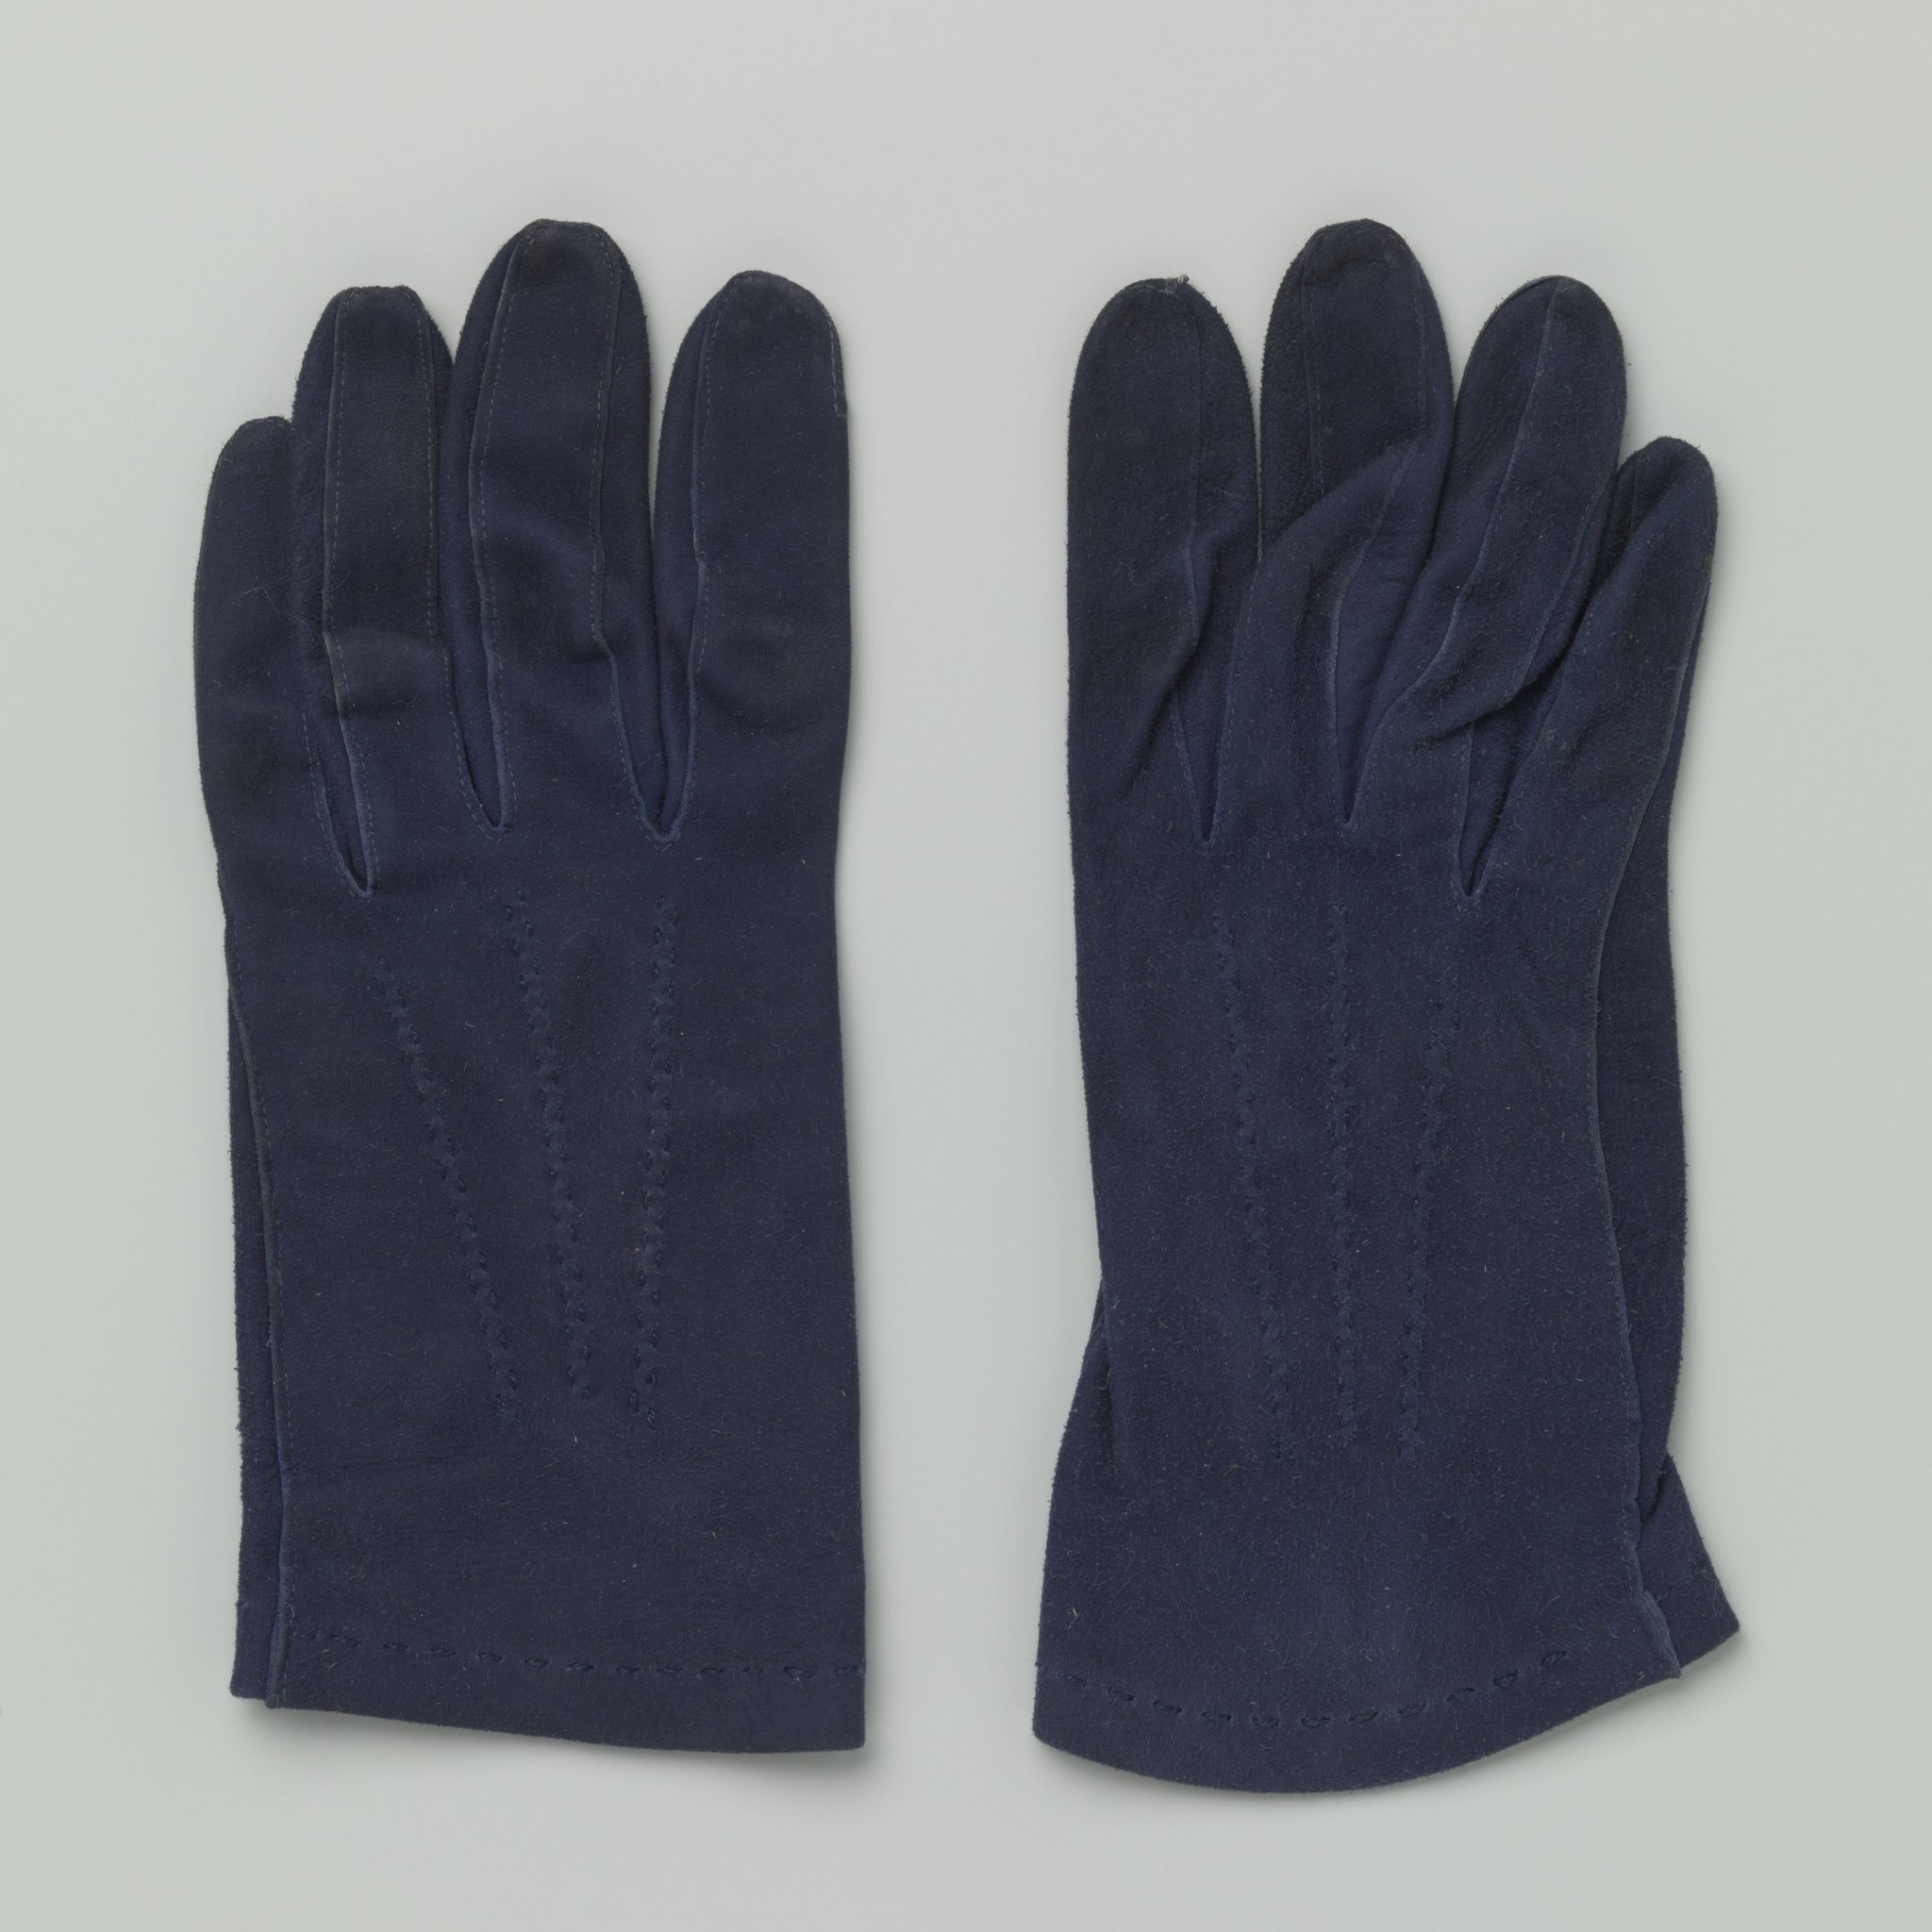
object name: glove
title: Handschoen van blauwe suède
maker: Anonymous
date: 1950-1960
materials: leather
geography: france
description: Linkerhandschoen van blauwe suède, op de rug drie uitstralende koorden en bij de pols een split.